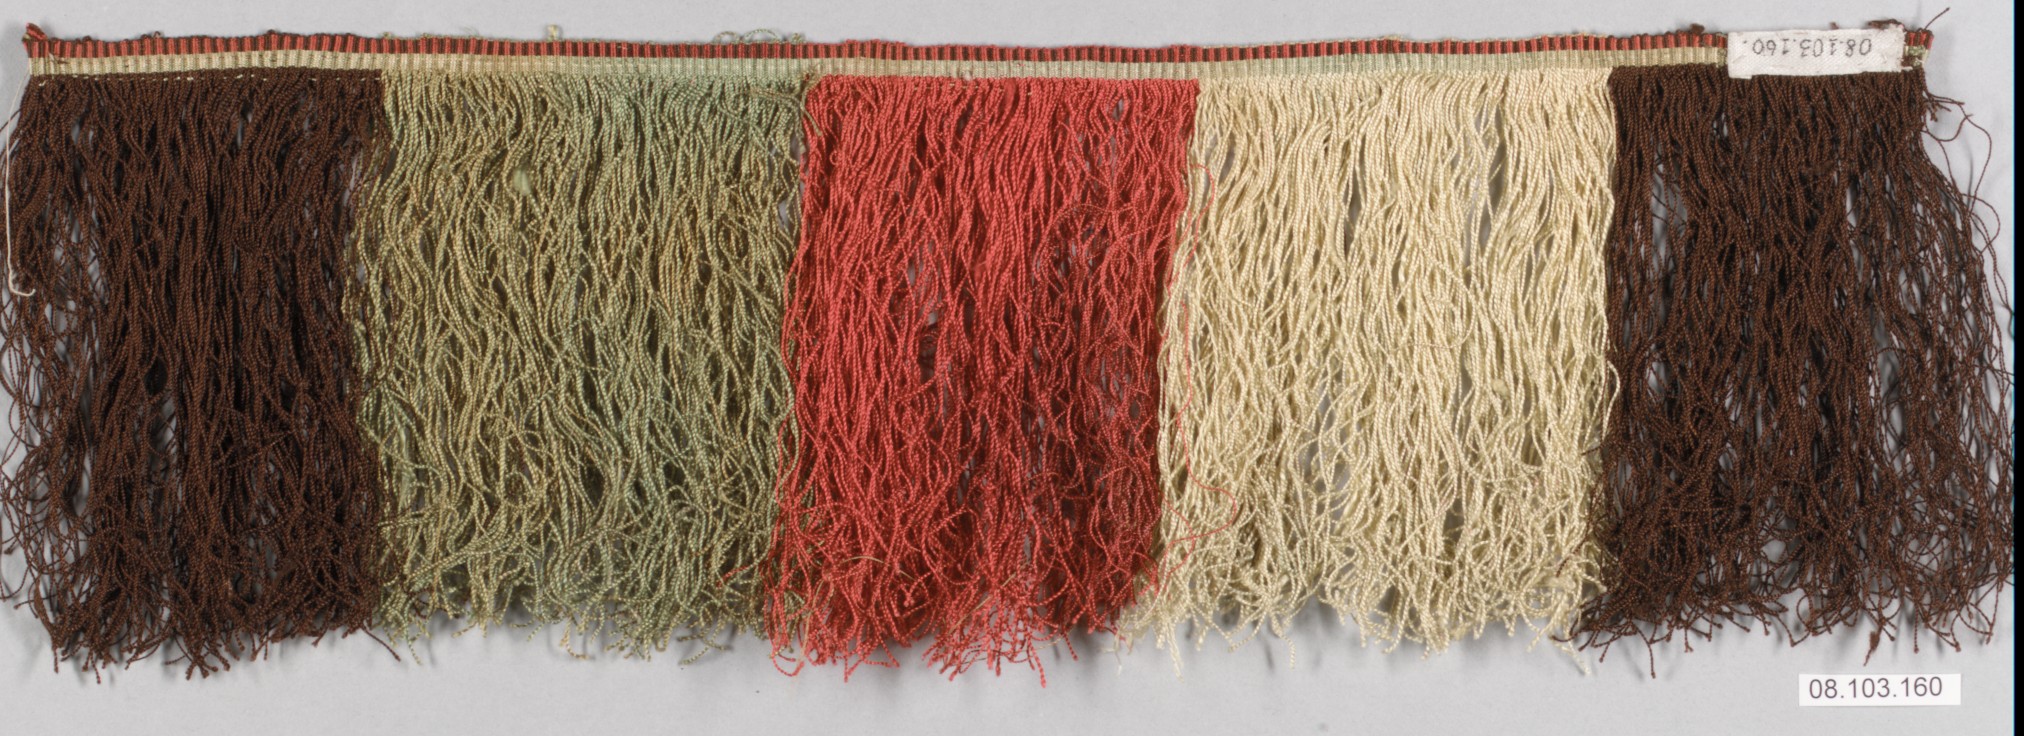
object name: fringe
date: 1801-1900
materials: silk